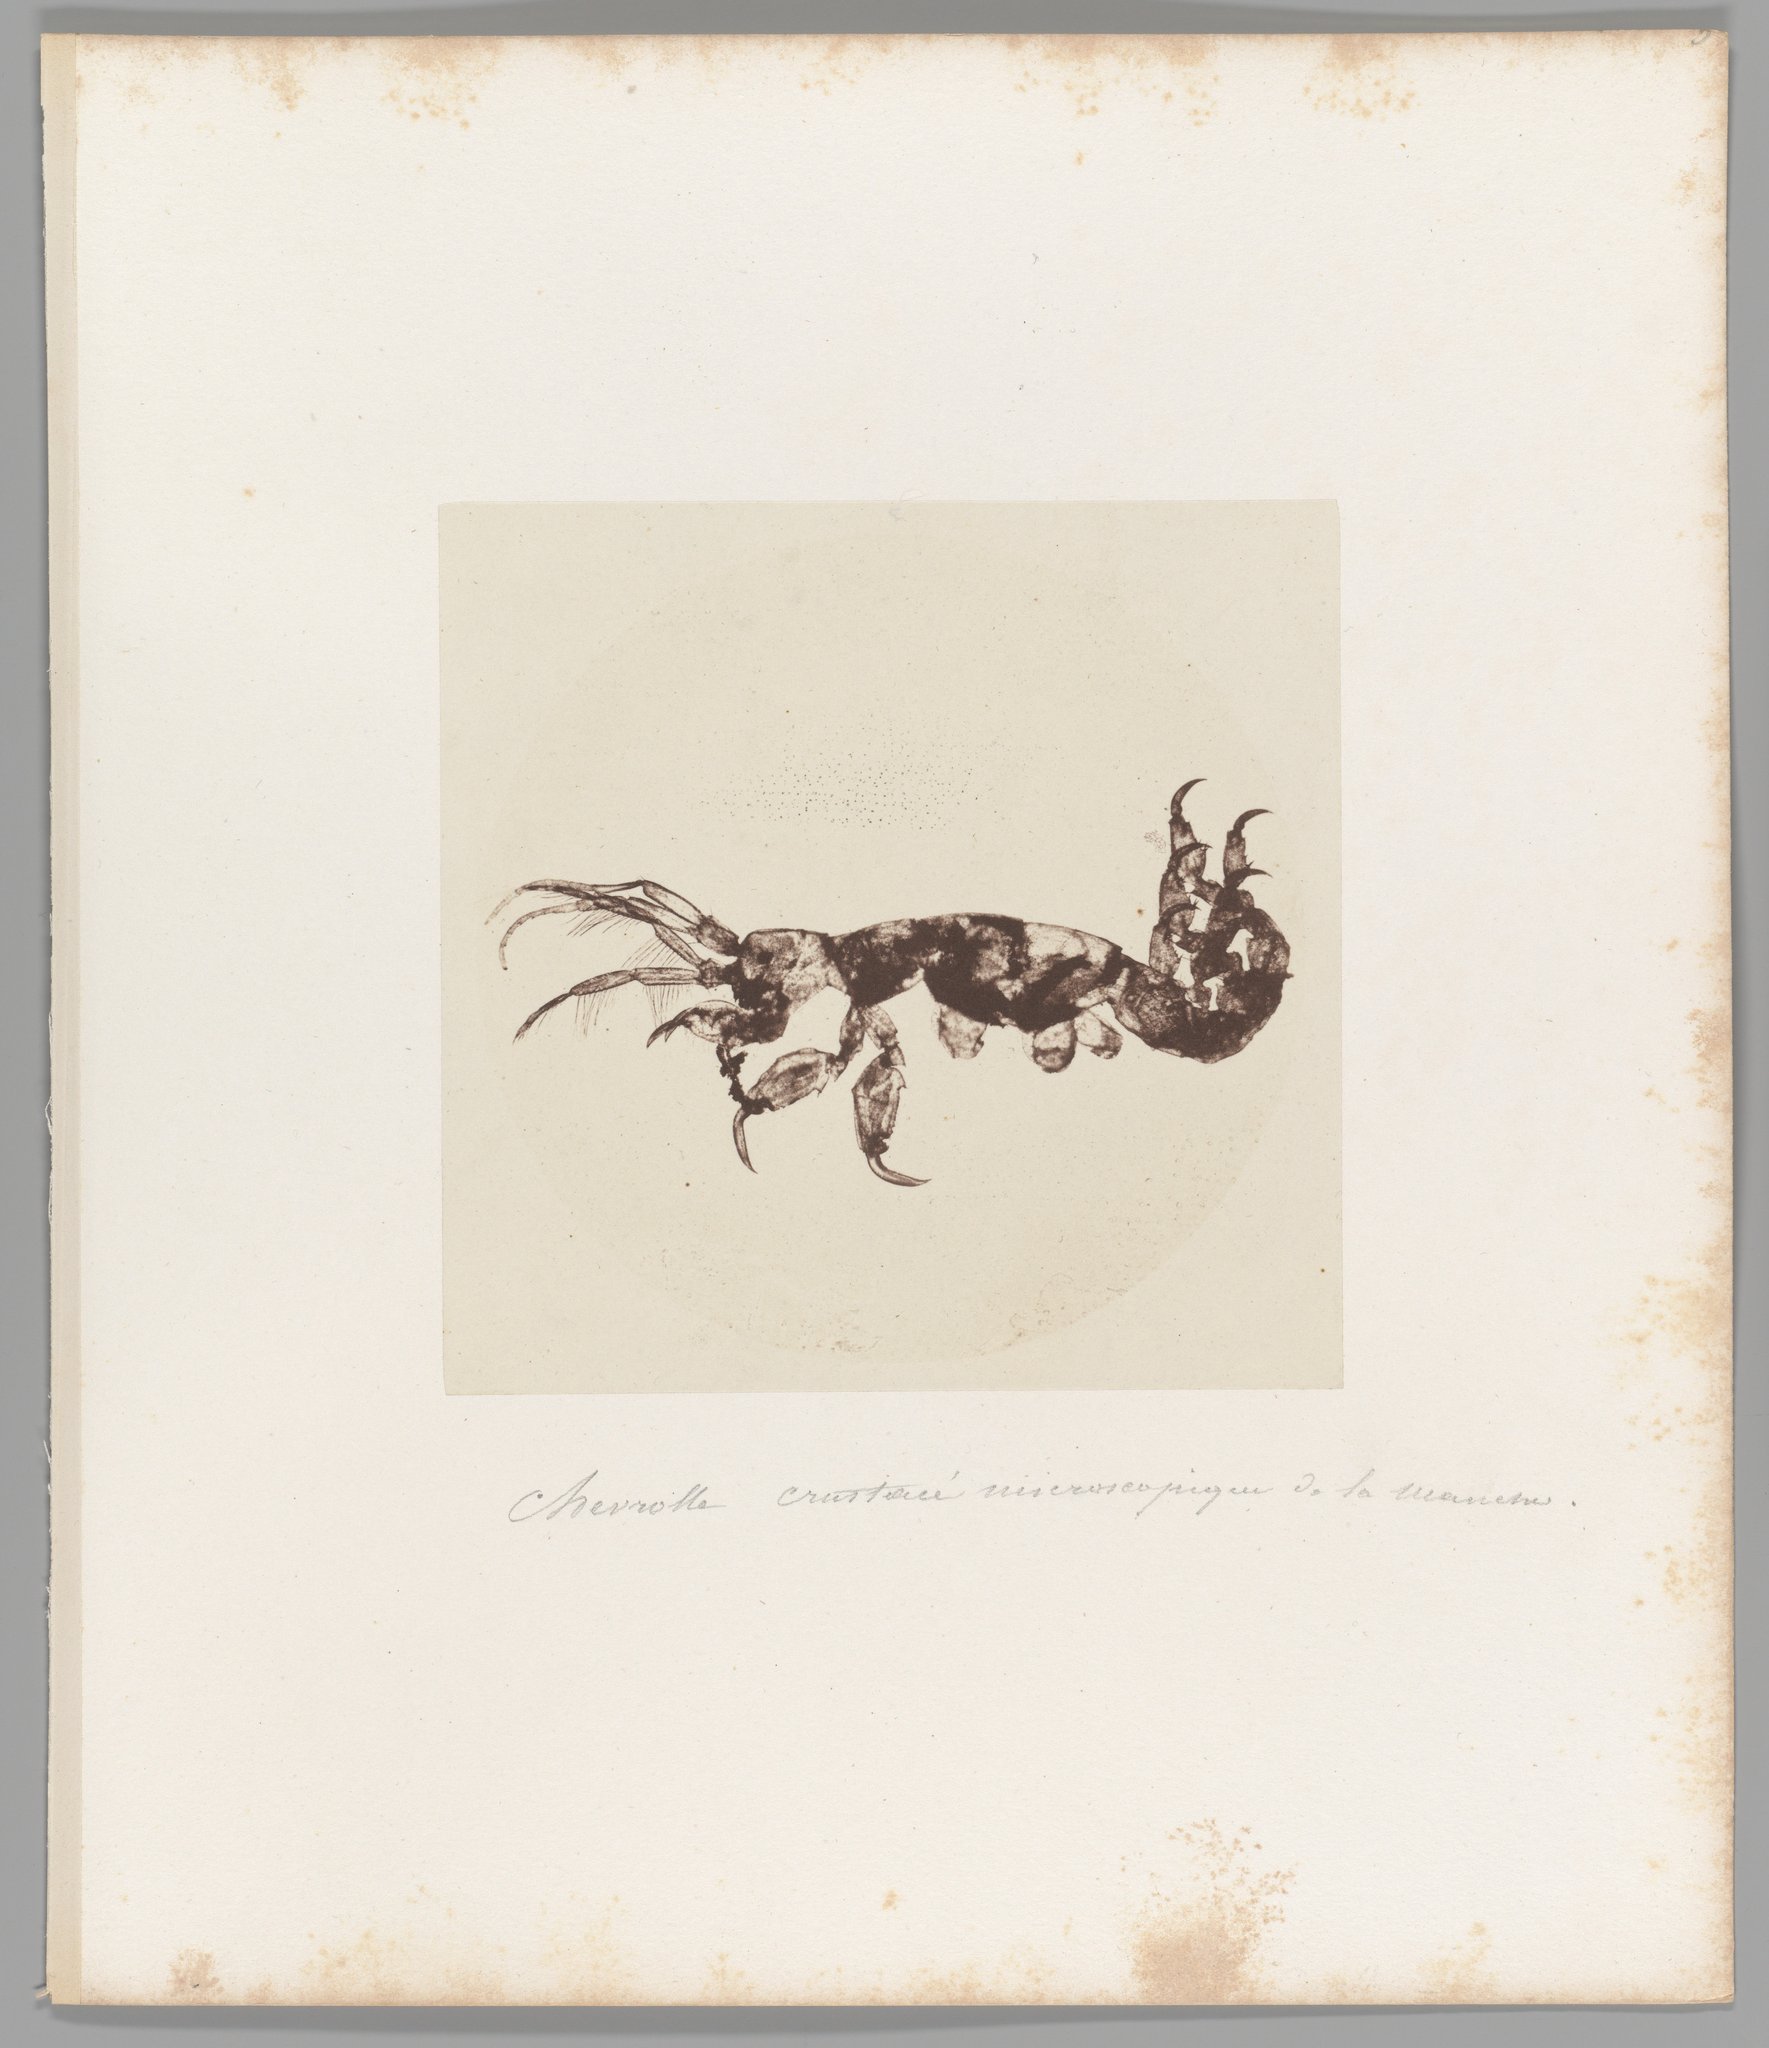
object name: photograph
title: [Untitled]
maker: auguste-adolphe bertsch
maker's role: artist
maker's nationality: french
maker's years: 1813-1871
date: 1853-1857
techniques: salted paper print